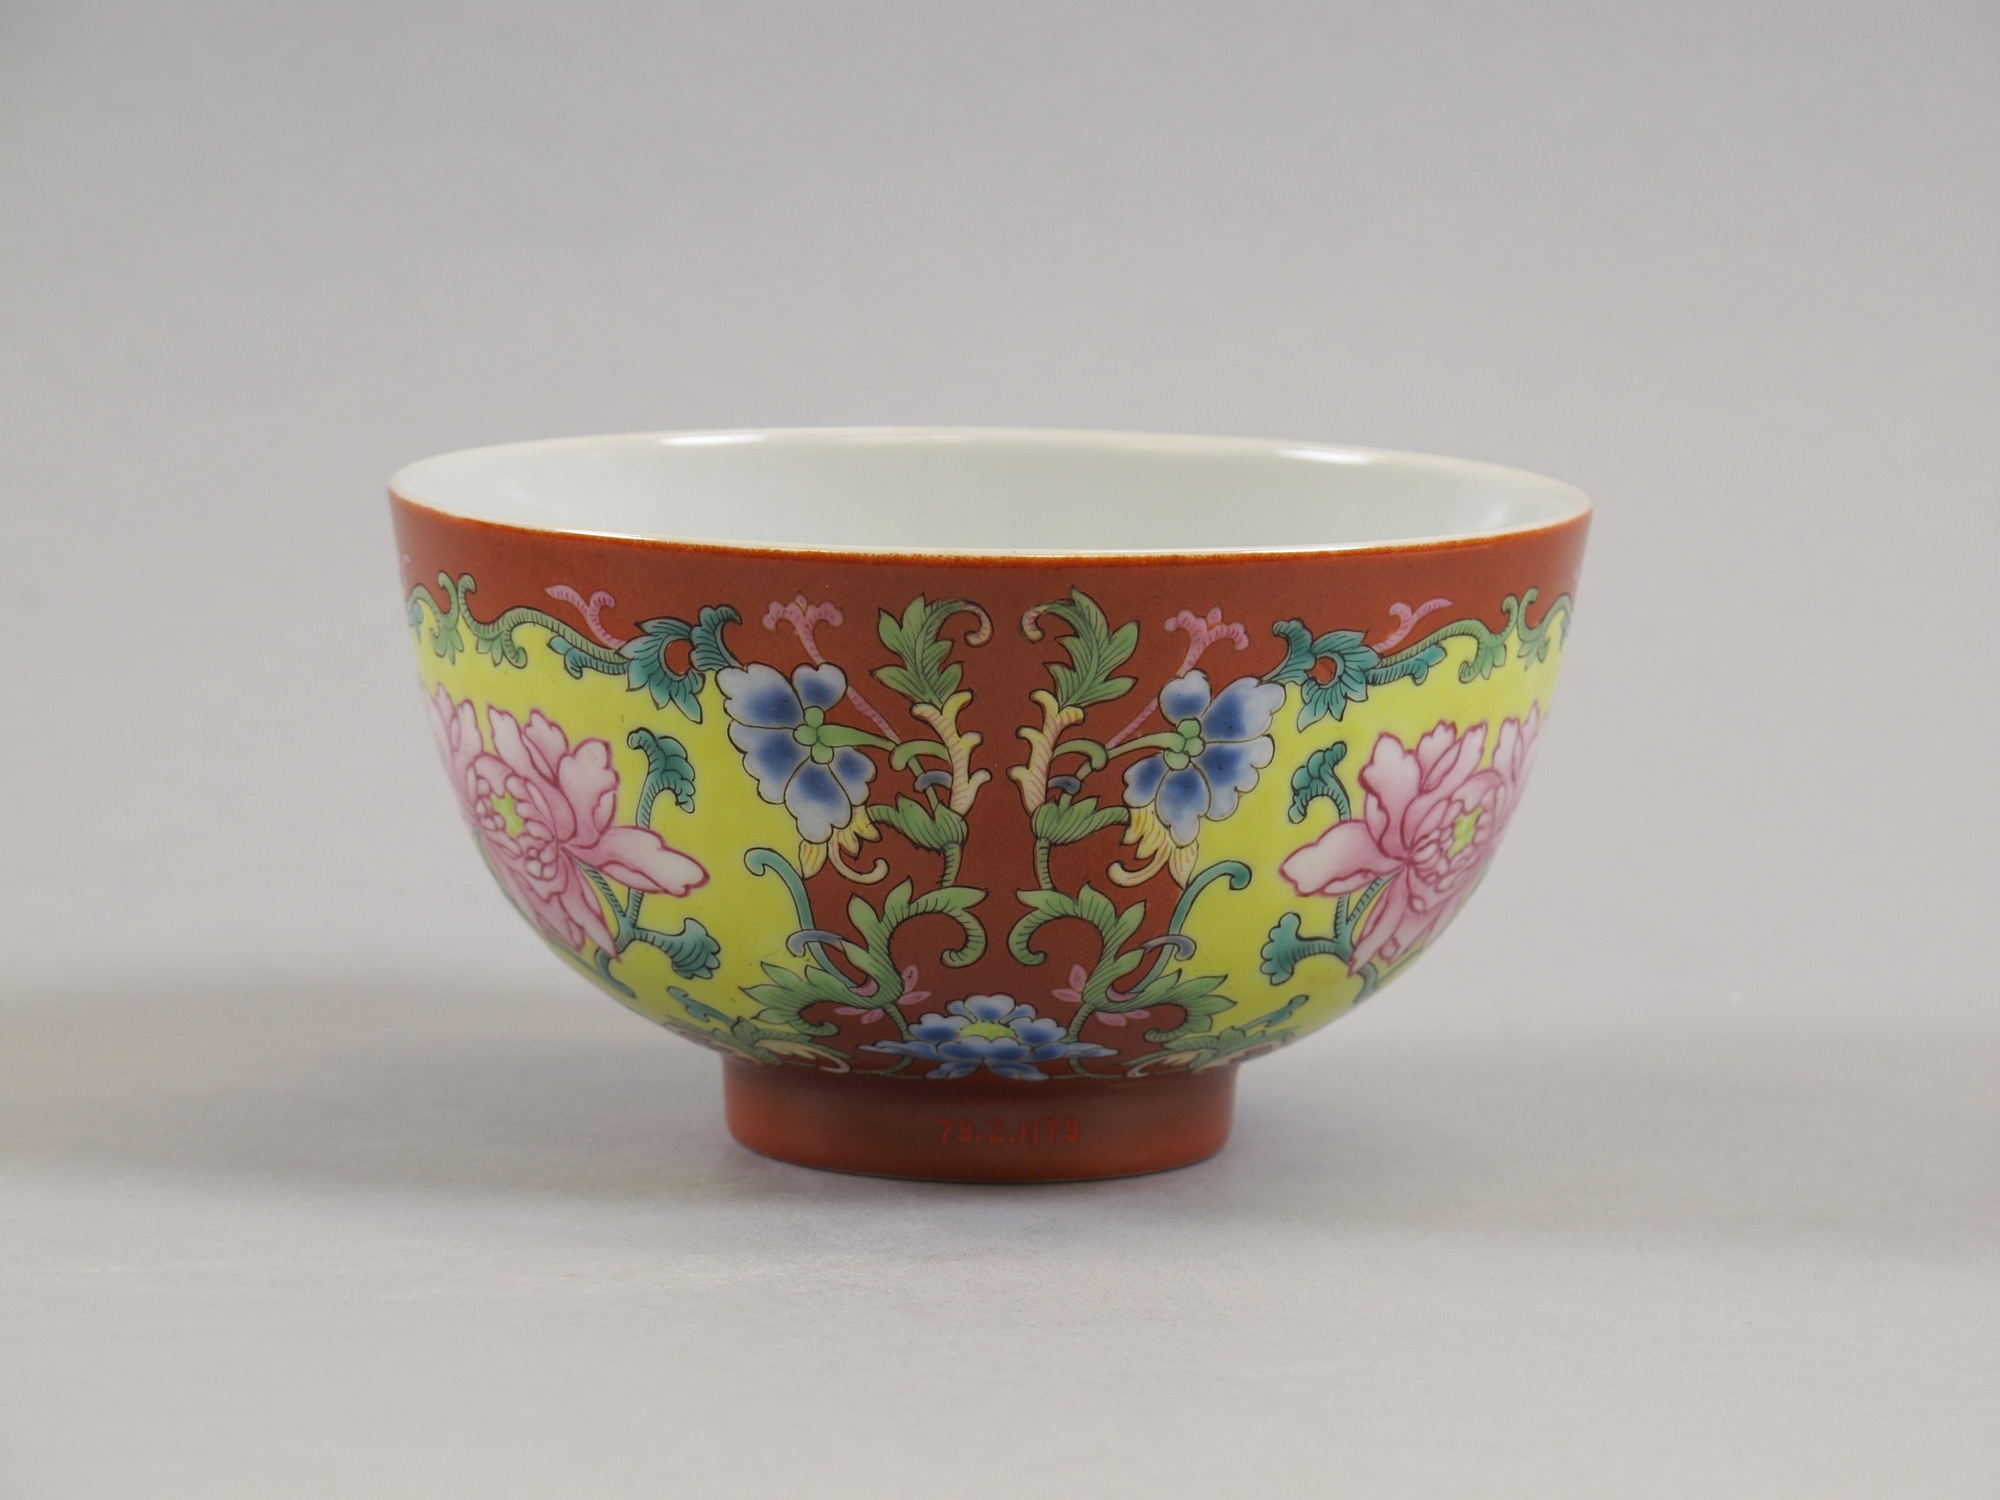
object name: bowl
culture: chinese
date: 1821-1850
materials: enamel, porcelain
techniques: overglaze, painting, polychrome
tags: flowers